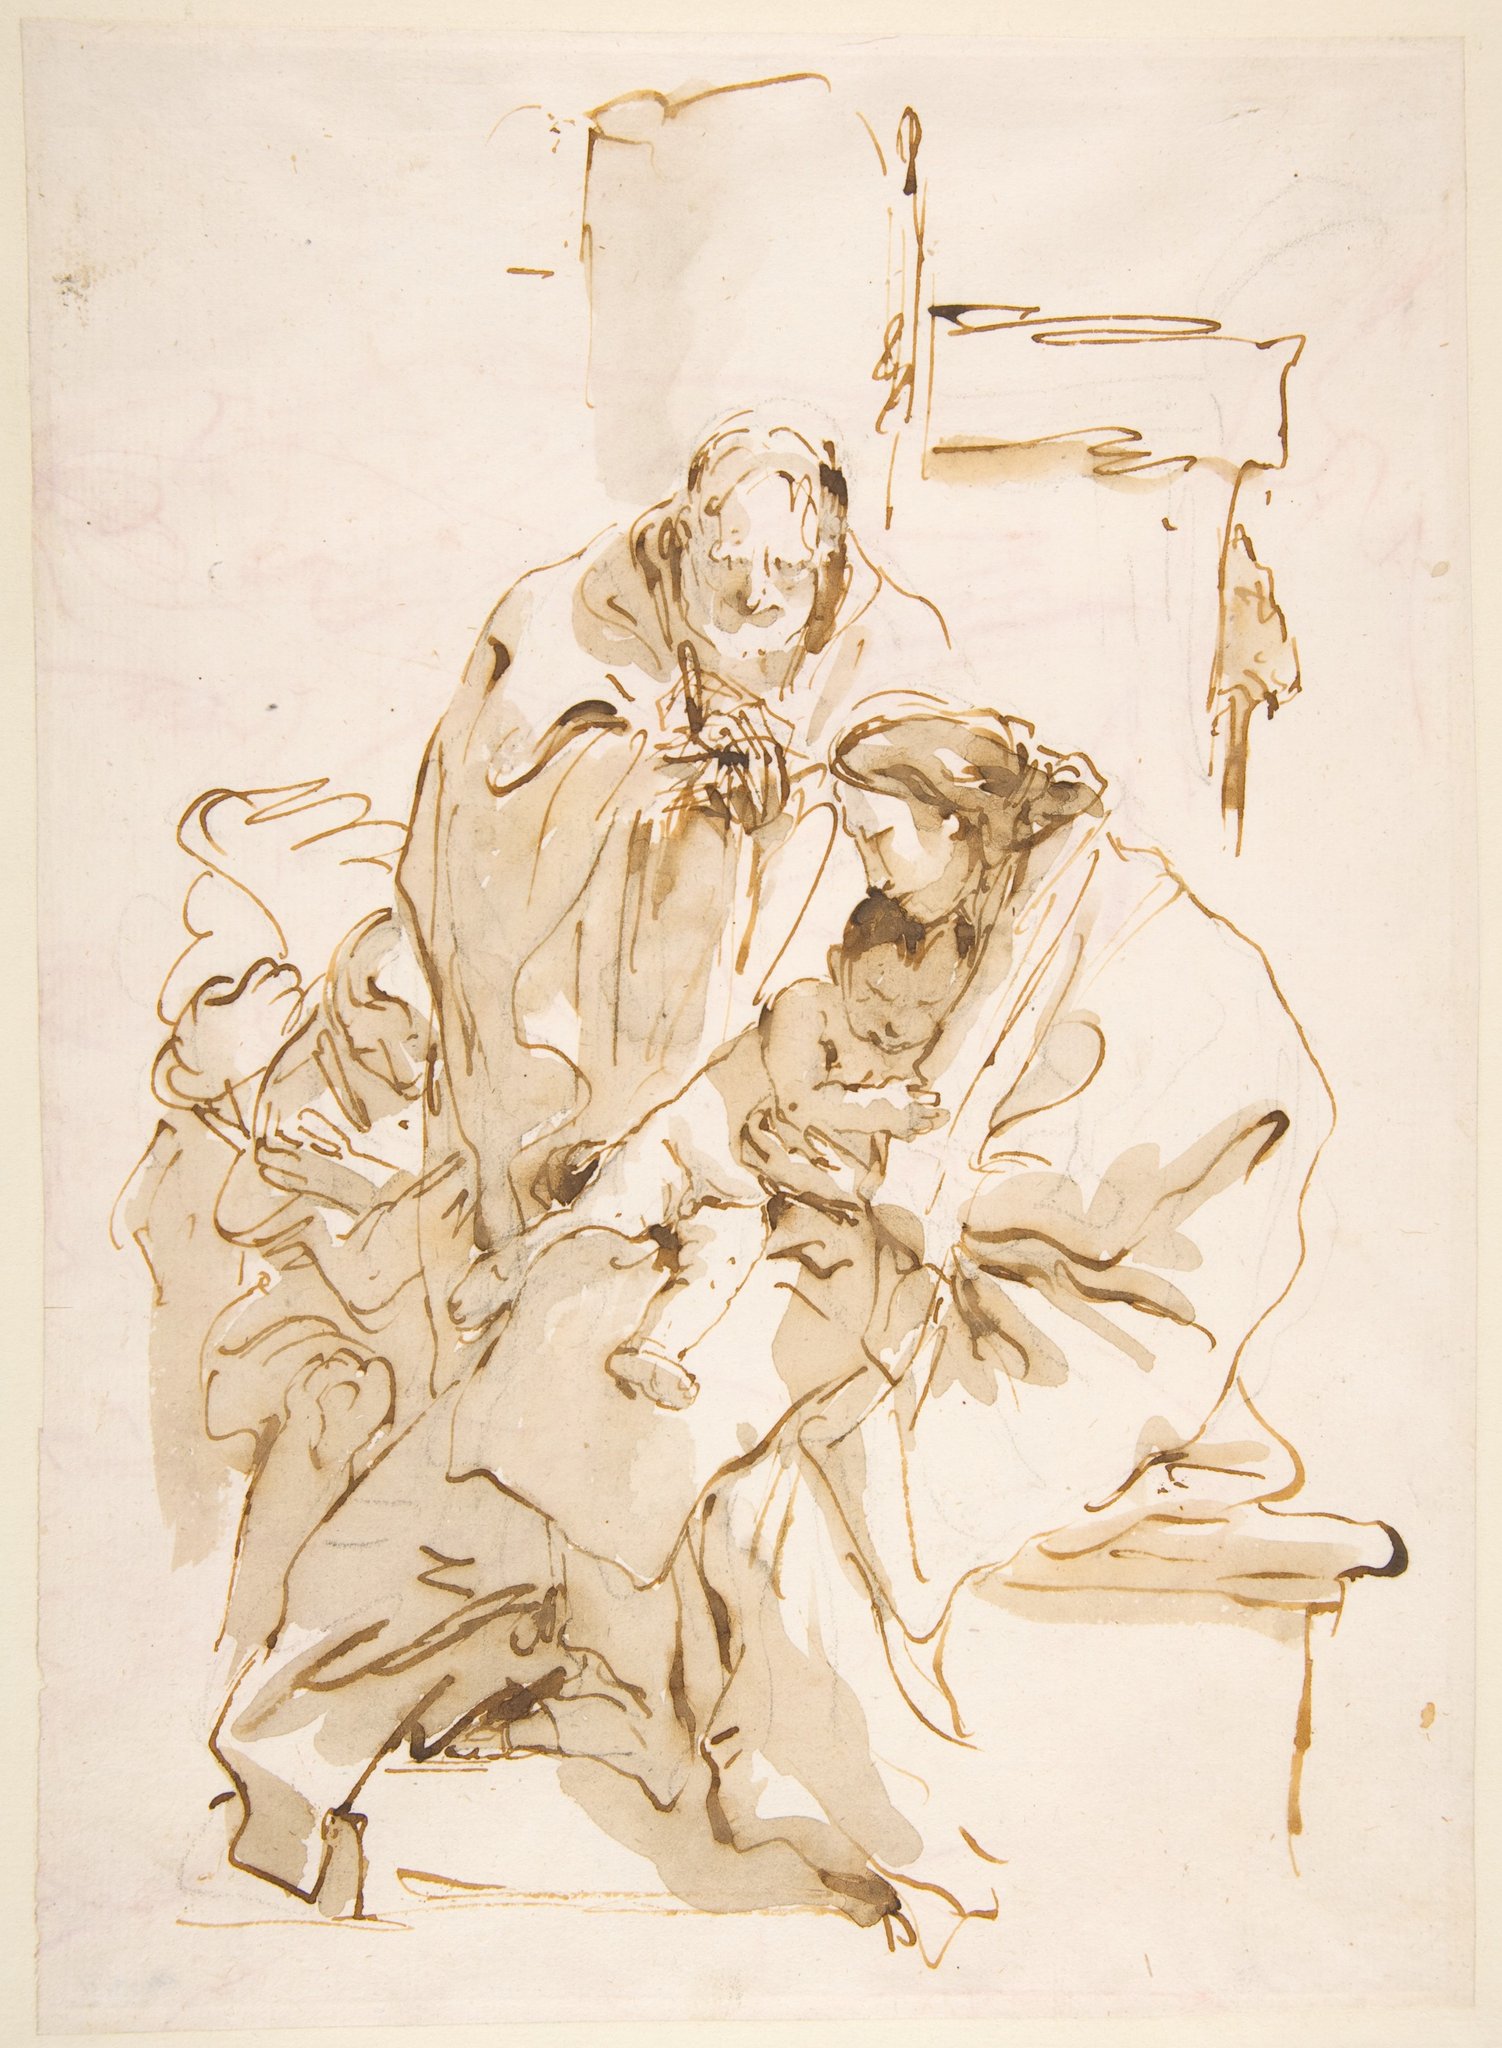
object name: drawing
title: The Holy Family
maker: giovanni battista tiepolo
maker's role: artist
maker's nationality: italian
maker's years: 1696-1770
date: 1750-1757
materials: chalk, ink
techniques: brush, pen, wash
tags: holy family